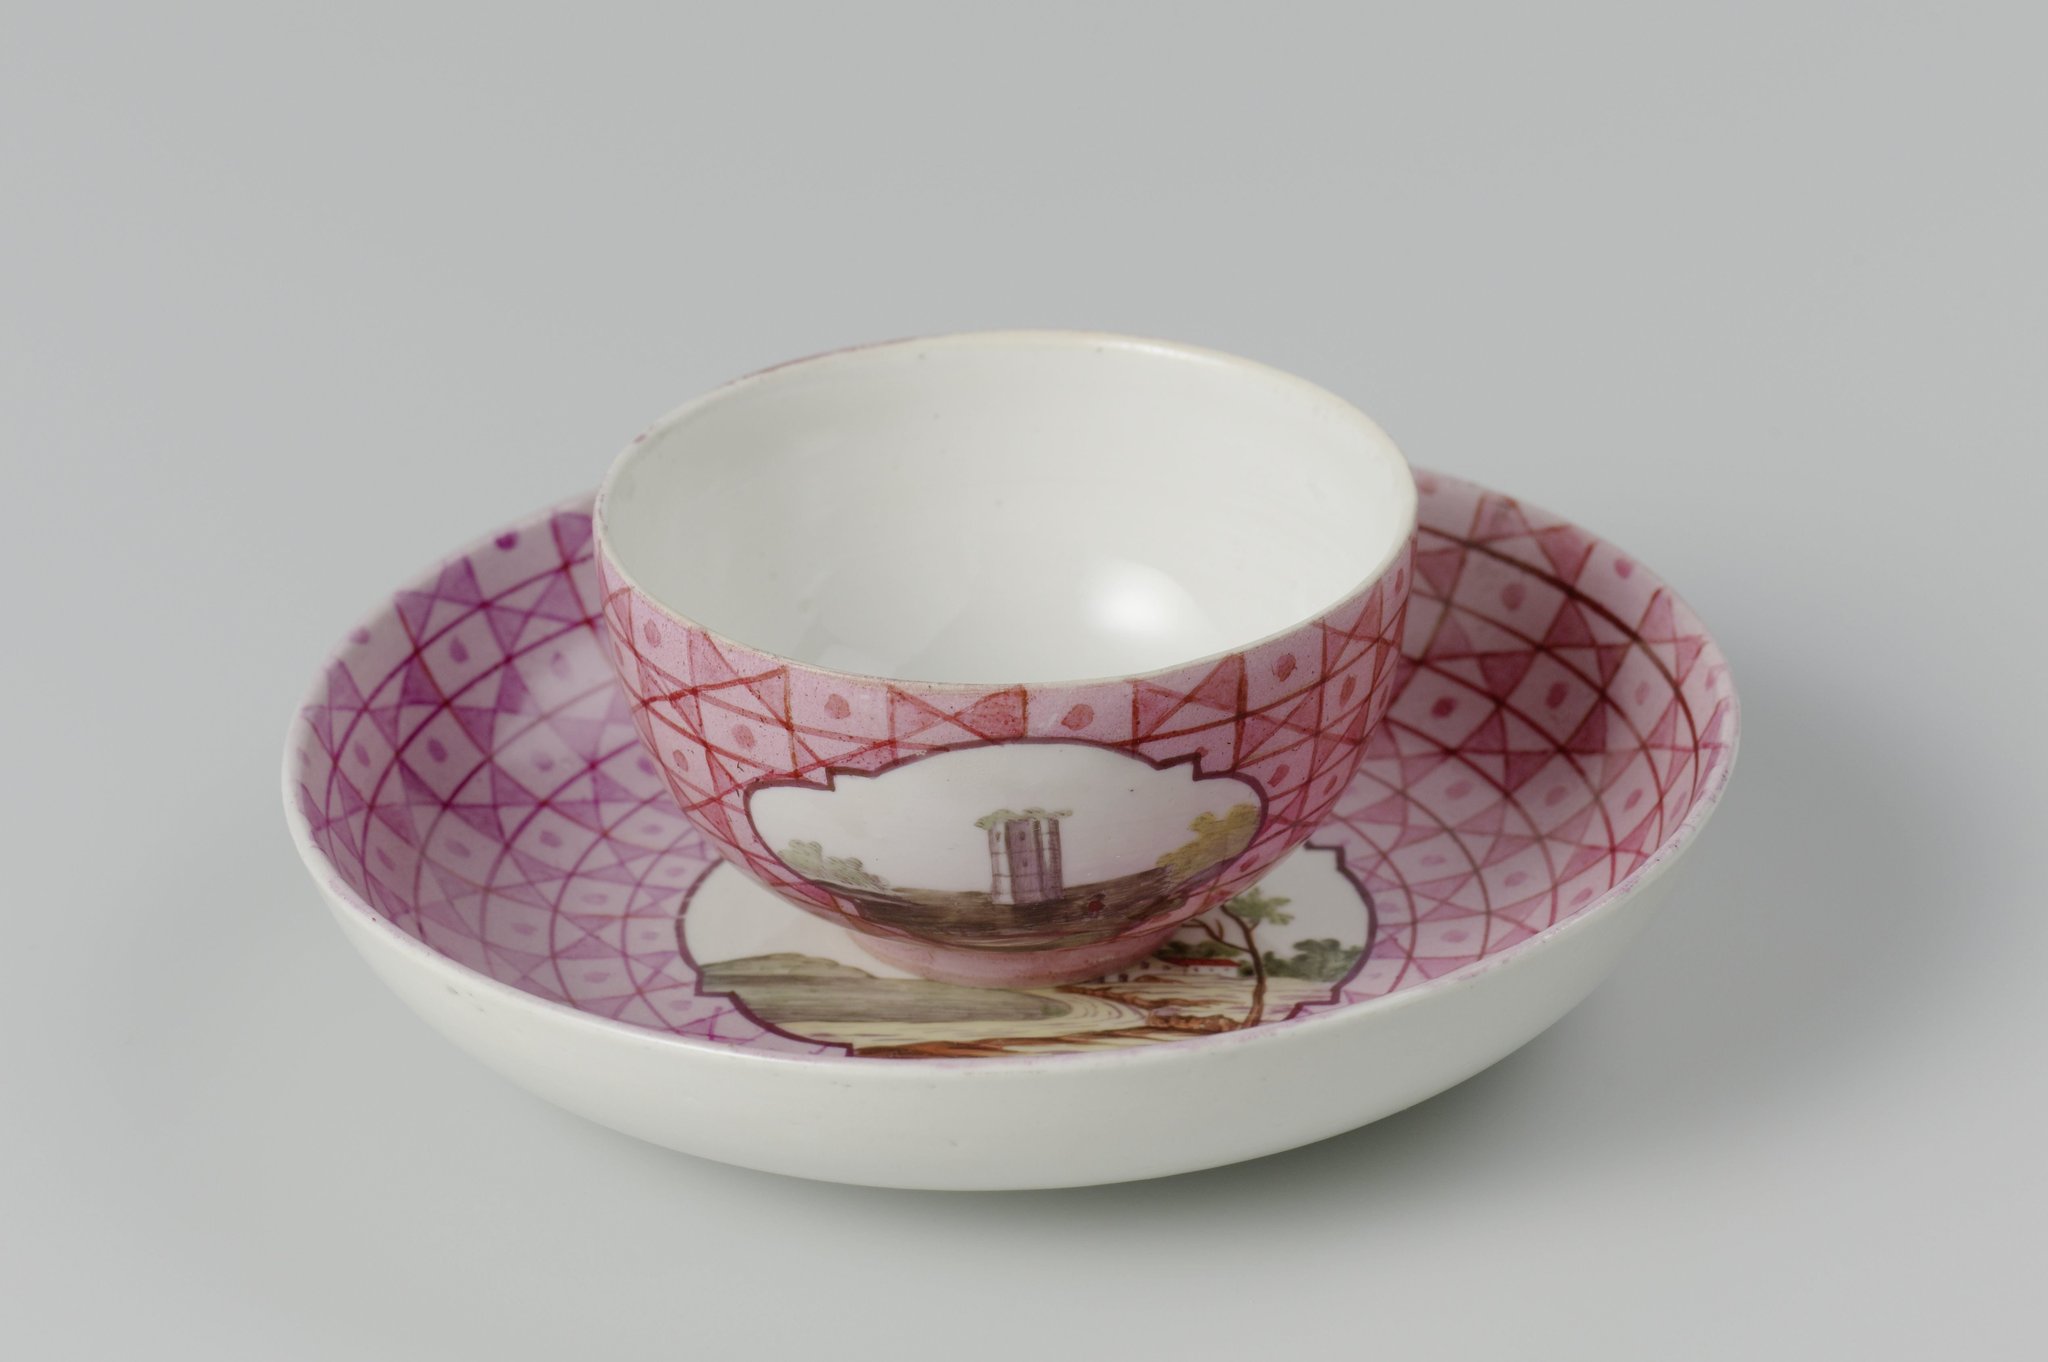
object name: kop en schotel, kop en schotel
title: Kop en schotel met een veelkleurig landschap in een medaillon uitgespaard in een geometrisch patroon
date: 1759-1771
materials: porcelain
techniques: painted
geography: weesp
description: Kop en schotel met een veelkleurig landschap in een medaillon gespaard in een paars geometrisch patroon. Gemerkt met twee gekruiste zwaarden en drie bollen in onderglazuurblauw, ingegrift 2.